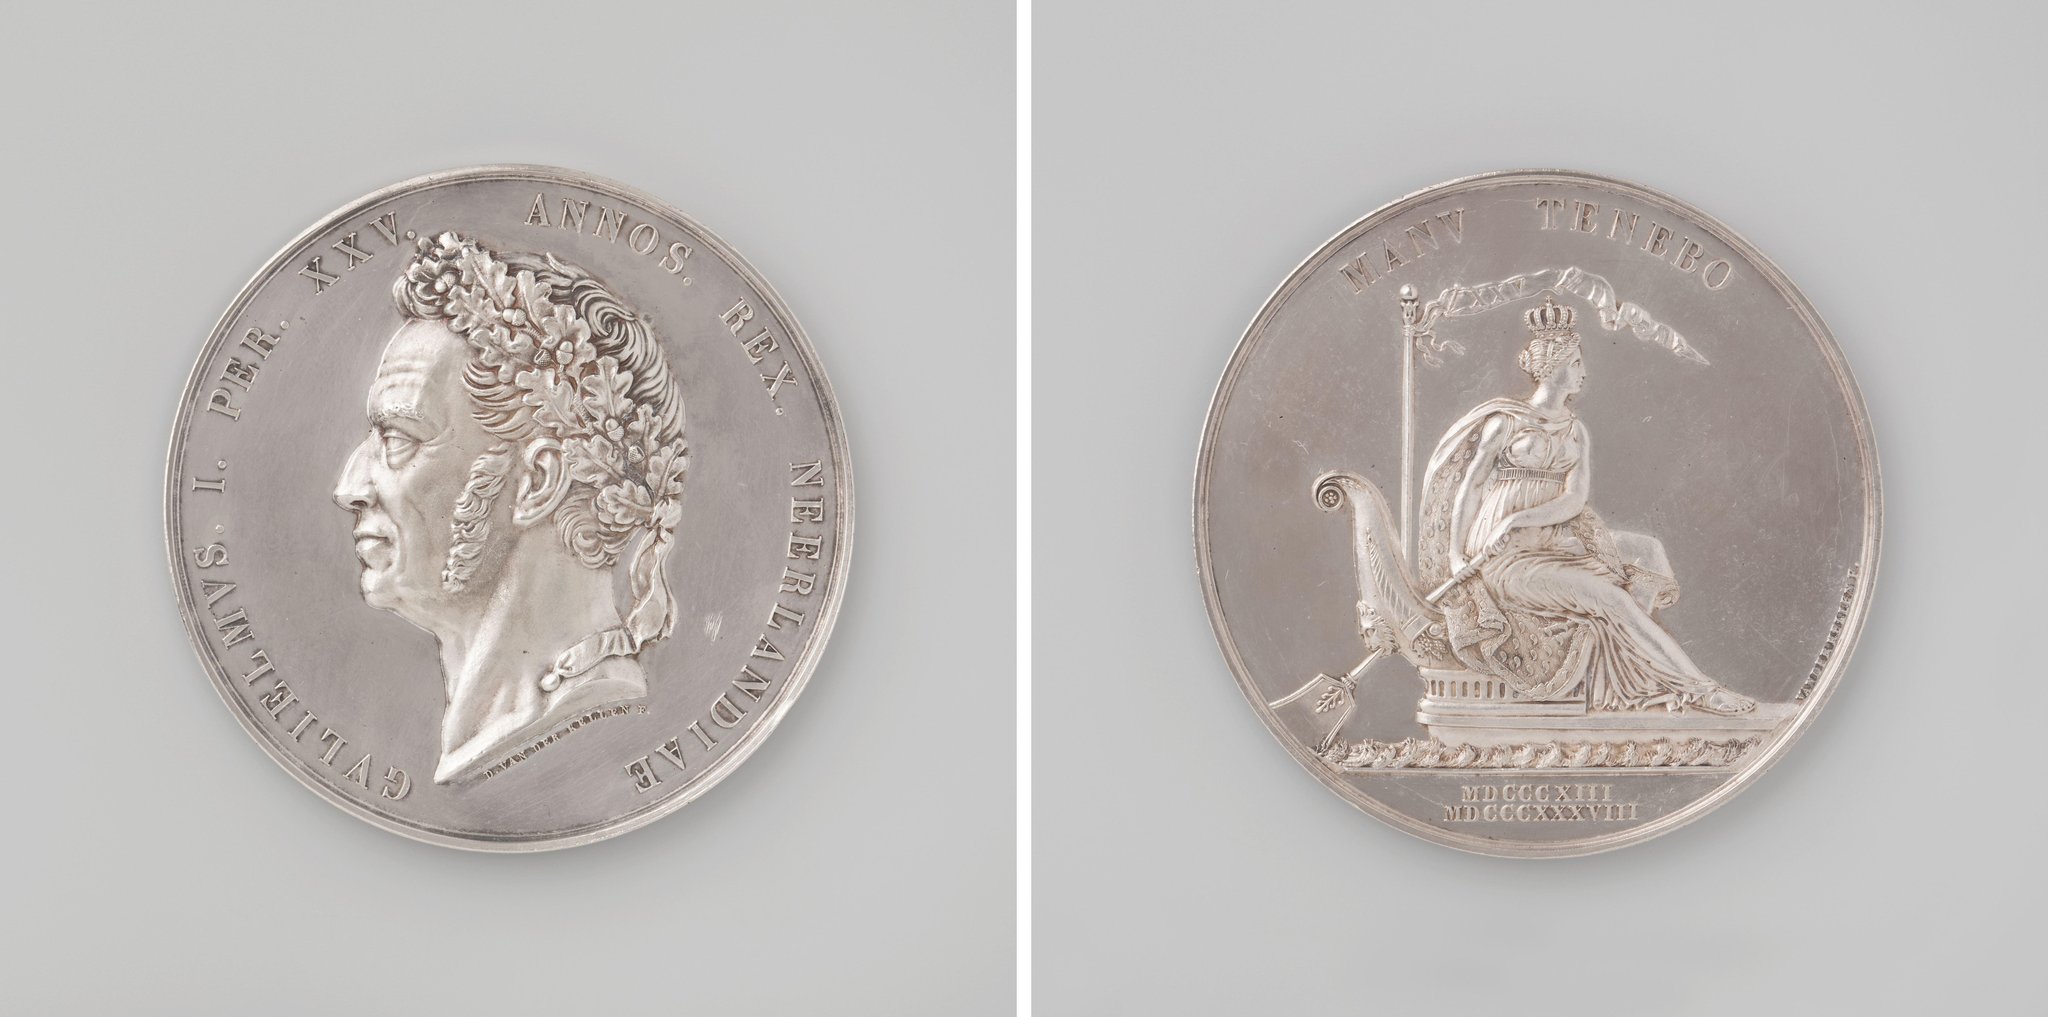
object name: history medal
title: Vijfentwintigjarig regeringsjubileum van Willem I Frederik, koning der Nederlanden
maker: david van der kellen (1804-1879)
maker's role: die cutter, draughtsman, print maker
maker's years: 1804-1879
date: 1838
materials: silver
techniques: striking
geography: utrecht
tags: the hague, berlin, william i of the netherlands, low countries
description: Zilveren penning. Voorzijde: borststuk man met eikekrans binnen omschrift. Keerzijde: gekroonde vrouw methermelijnen mantel, voorstellende koningschap, zit onder wimpel met opschrift op antiekschip en houdt met beide handen roer vast binnen omschrift; afsnede: jaartal